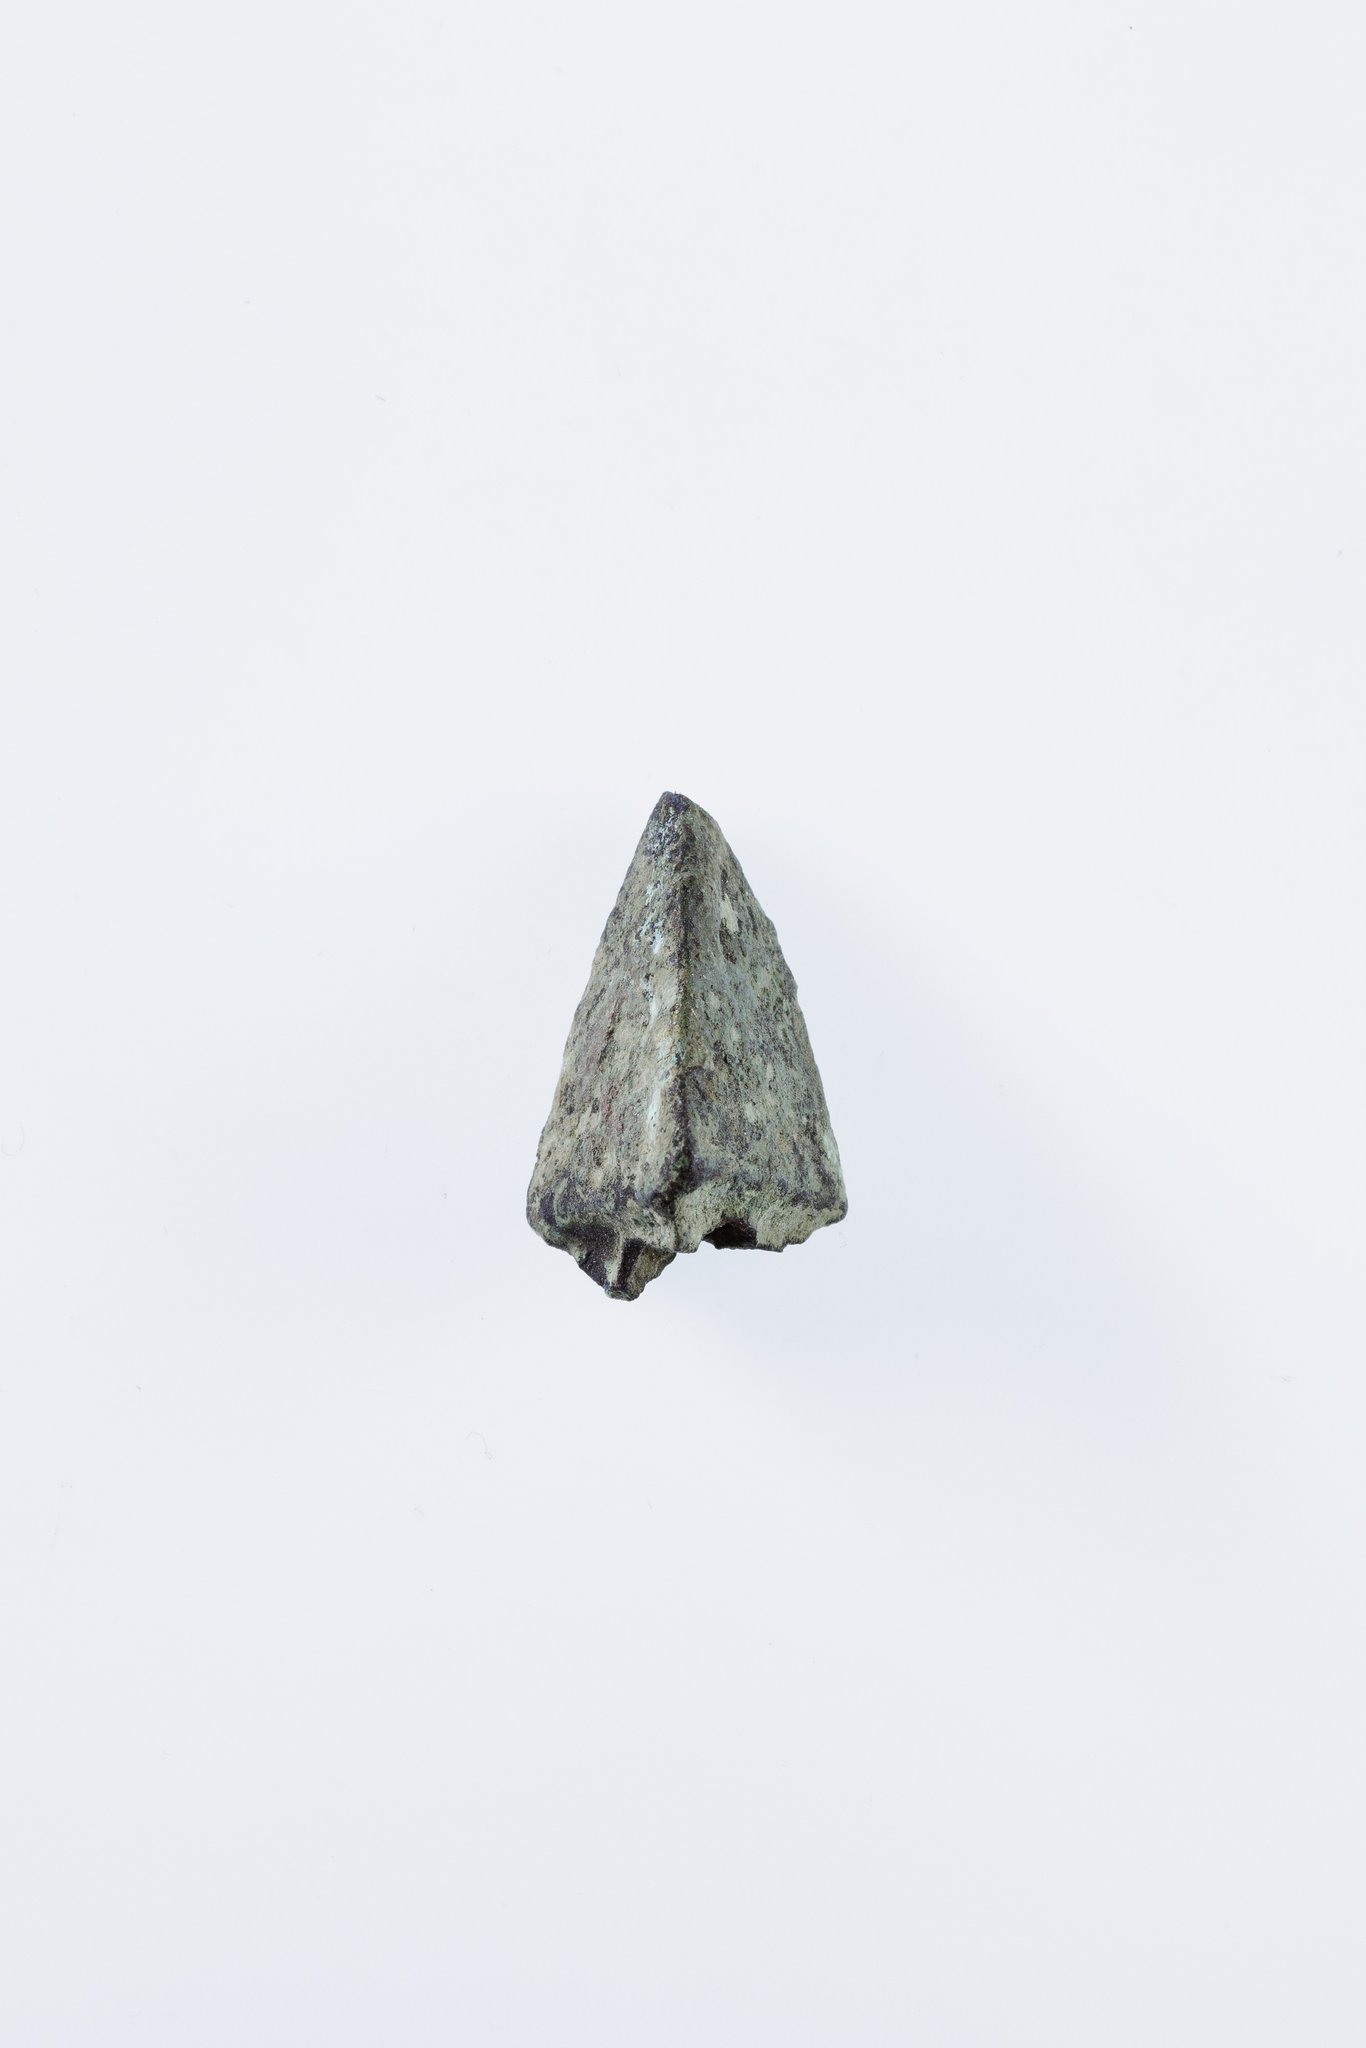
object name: arrow point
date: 664-525 BCE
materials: bronze, copper alloy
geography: egypt